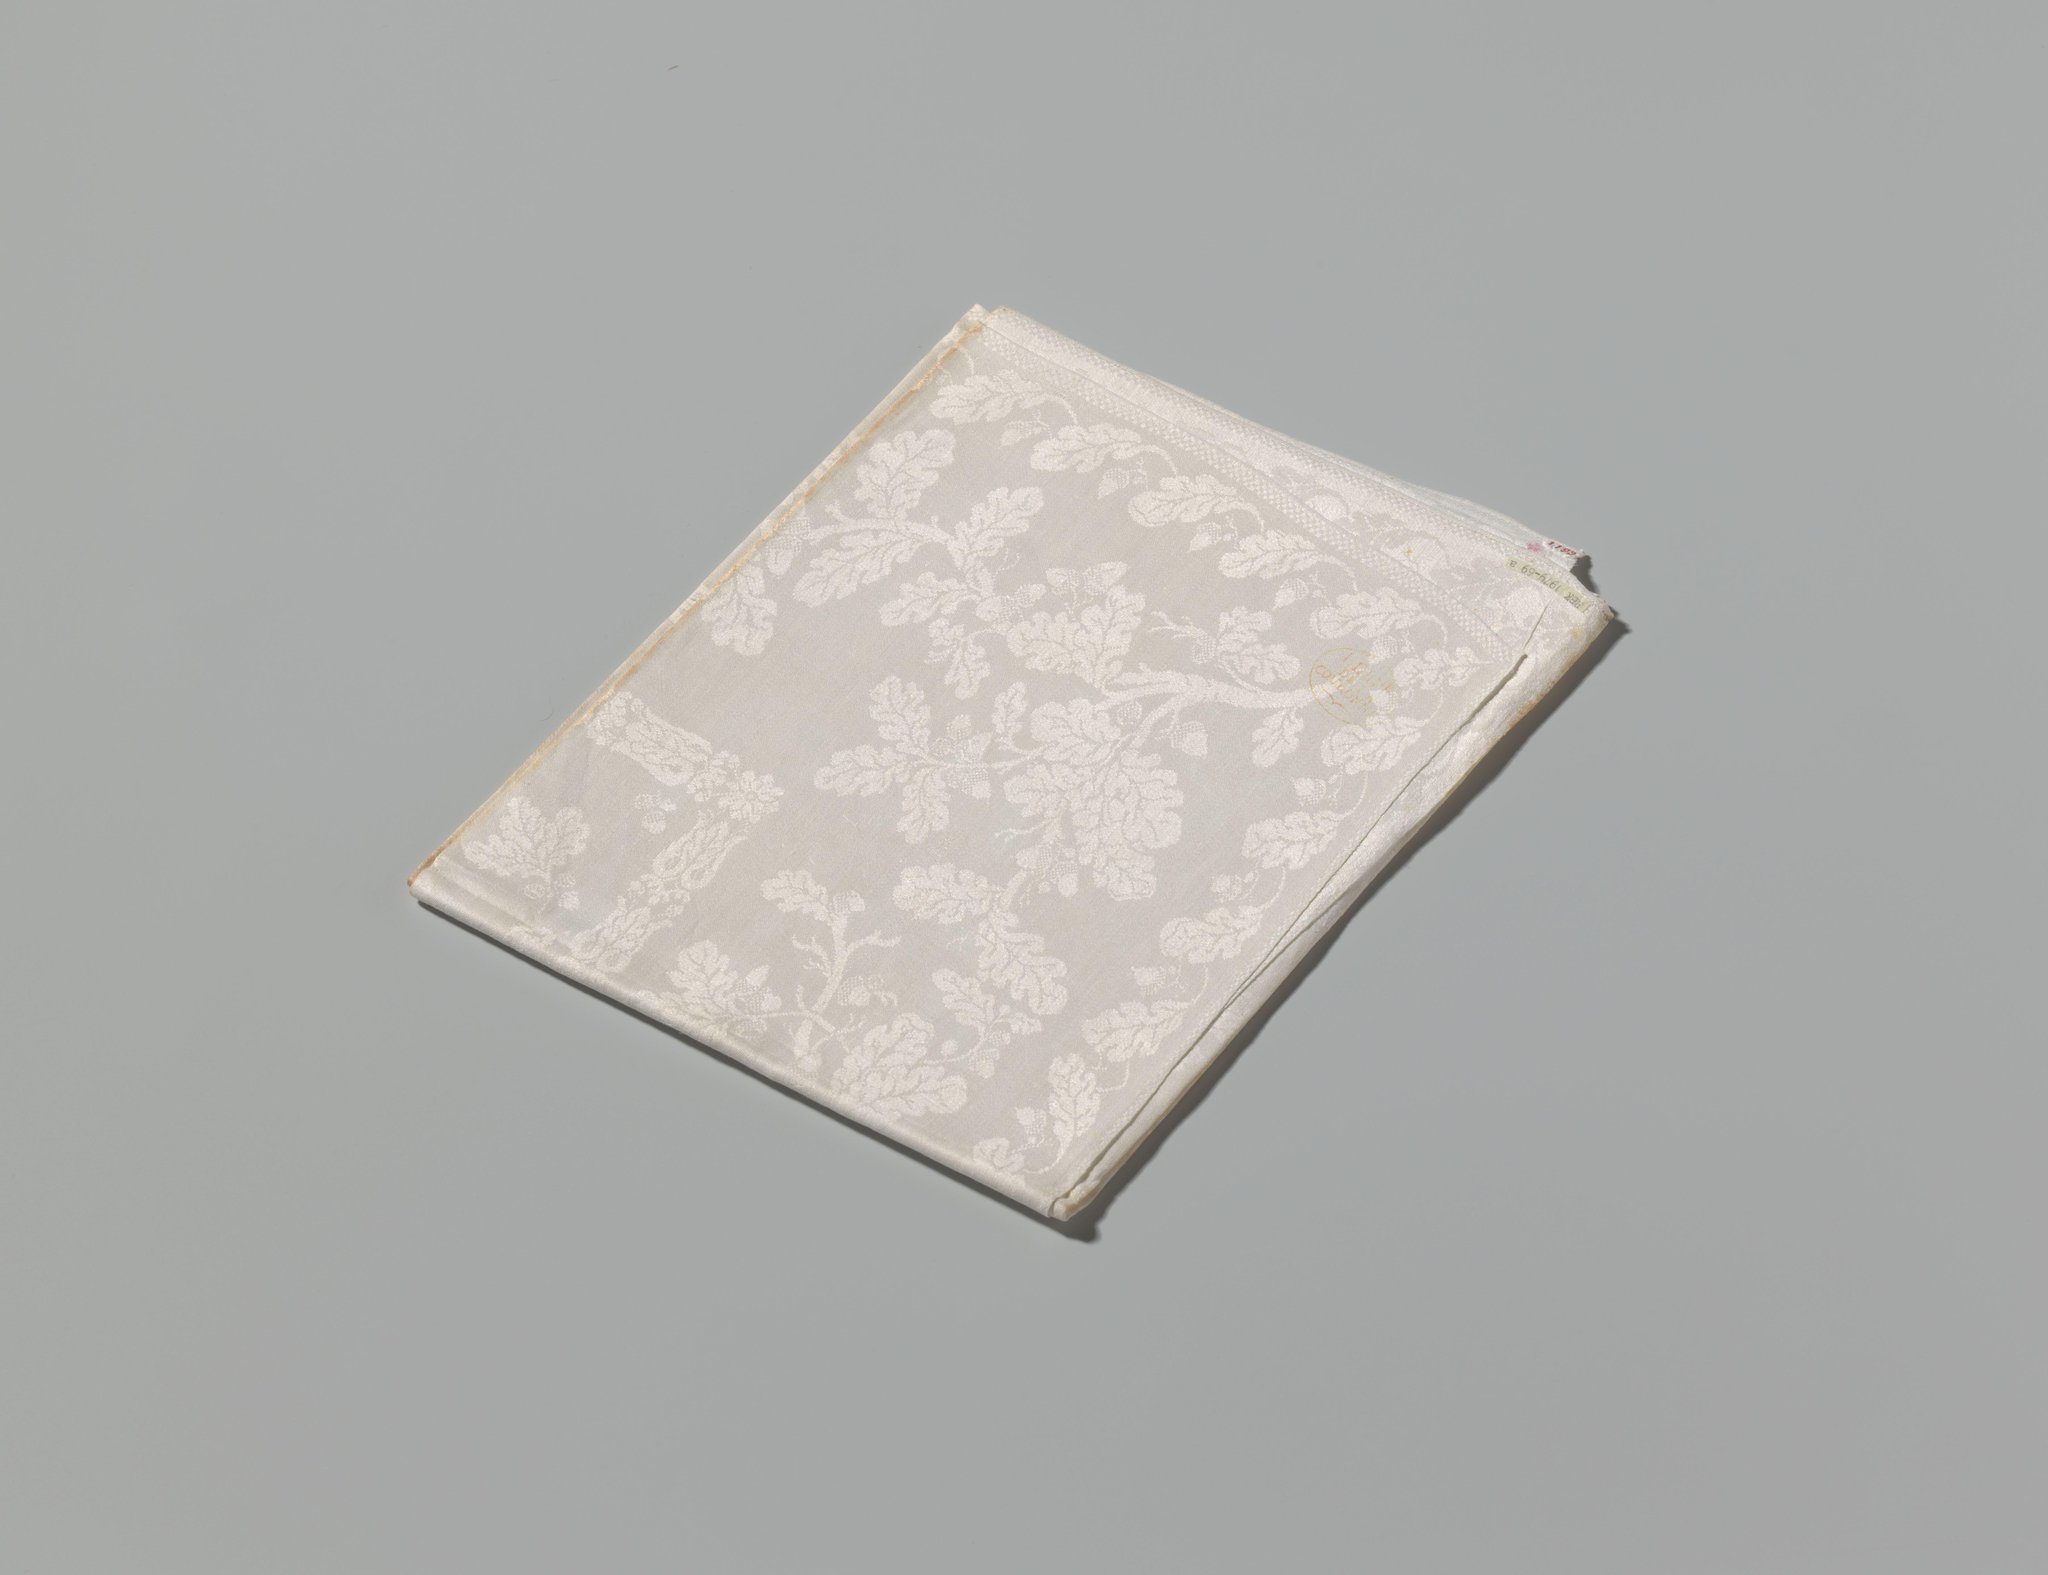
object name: napkin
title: Servet van linnendamast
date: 1800-1900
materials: linen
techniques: cross stitching, damask, weave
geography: netherlands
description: Servet van linnendamast met gestrooide eikenbladeren en eikels op het veld en een rand van eikentakken. Het servet is gemerkt in rood met een kruissteek: G52 en heeft een aangenaaid nummer: 1193 in rood op wit. Het servet heeft een stempel met de tekst: LINGie DE LA COURONNE (?).